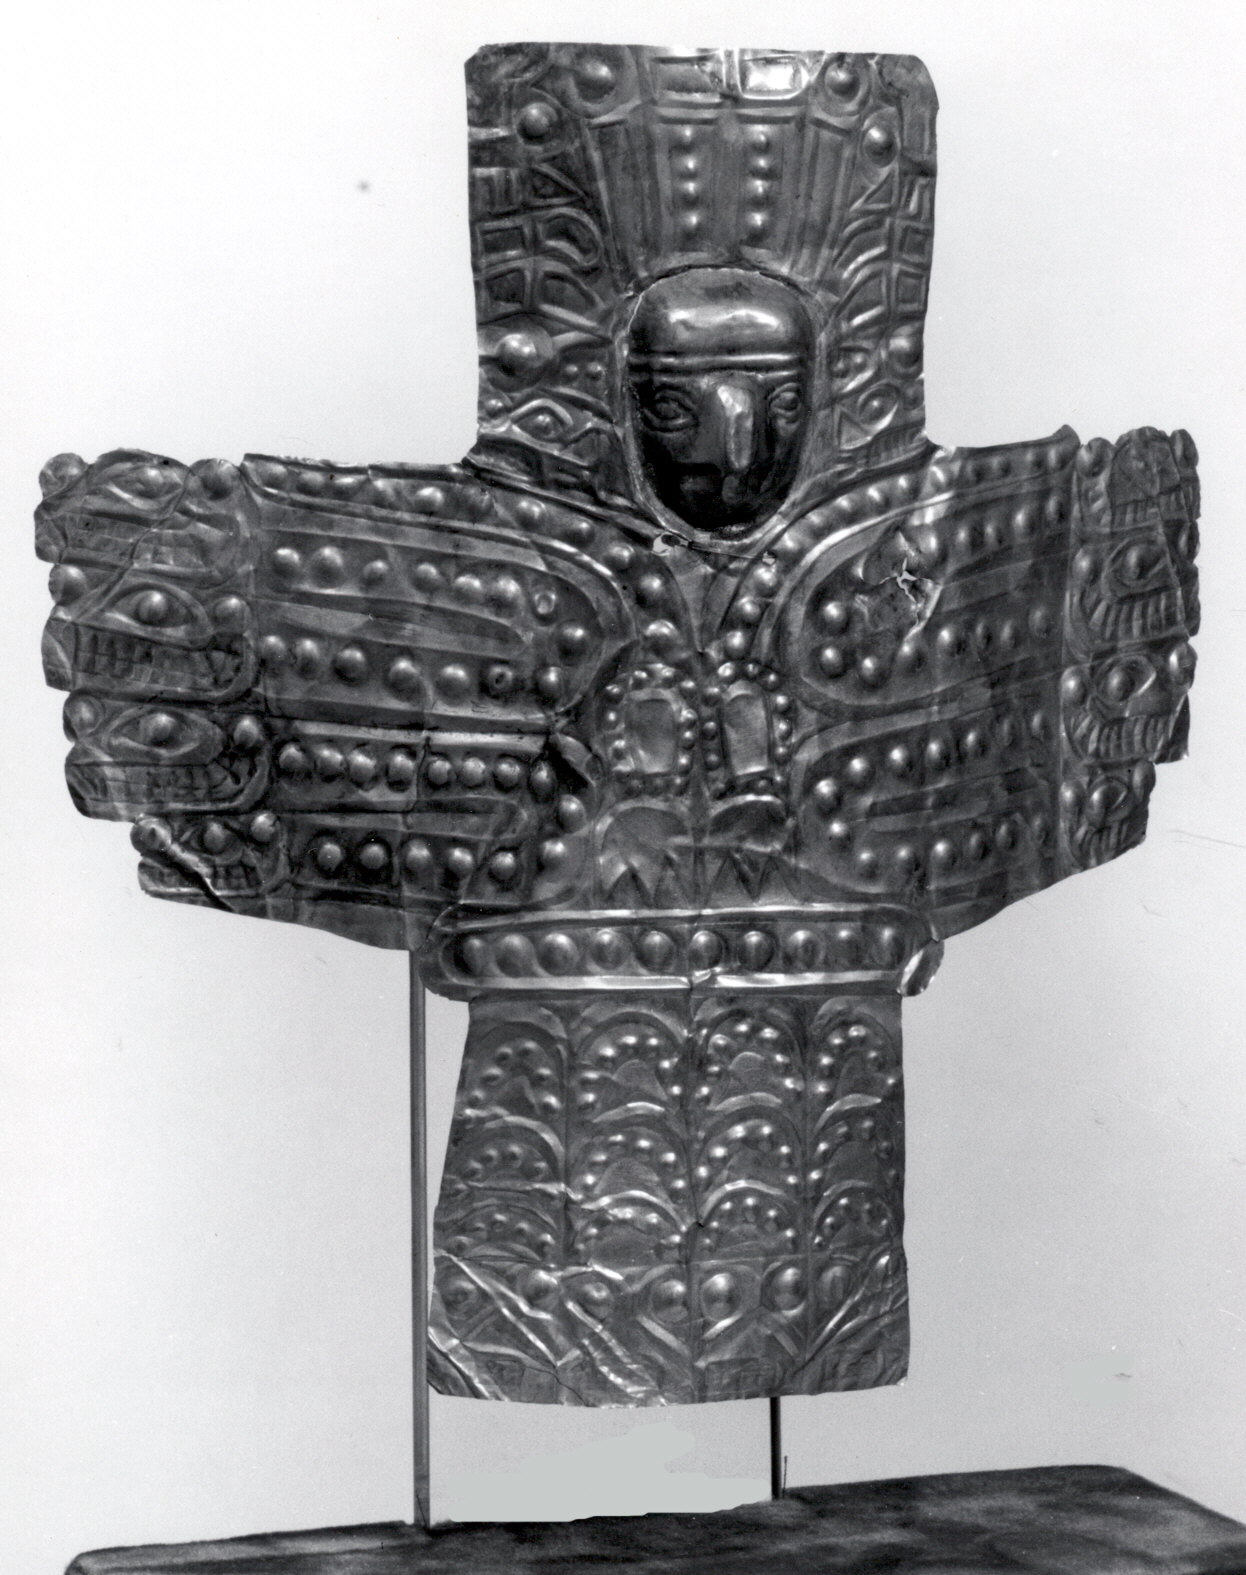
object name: ornament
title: Bird Ornament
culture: tiwanaku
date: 501-1000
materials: gold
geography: peru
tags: birds